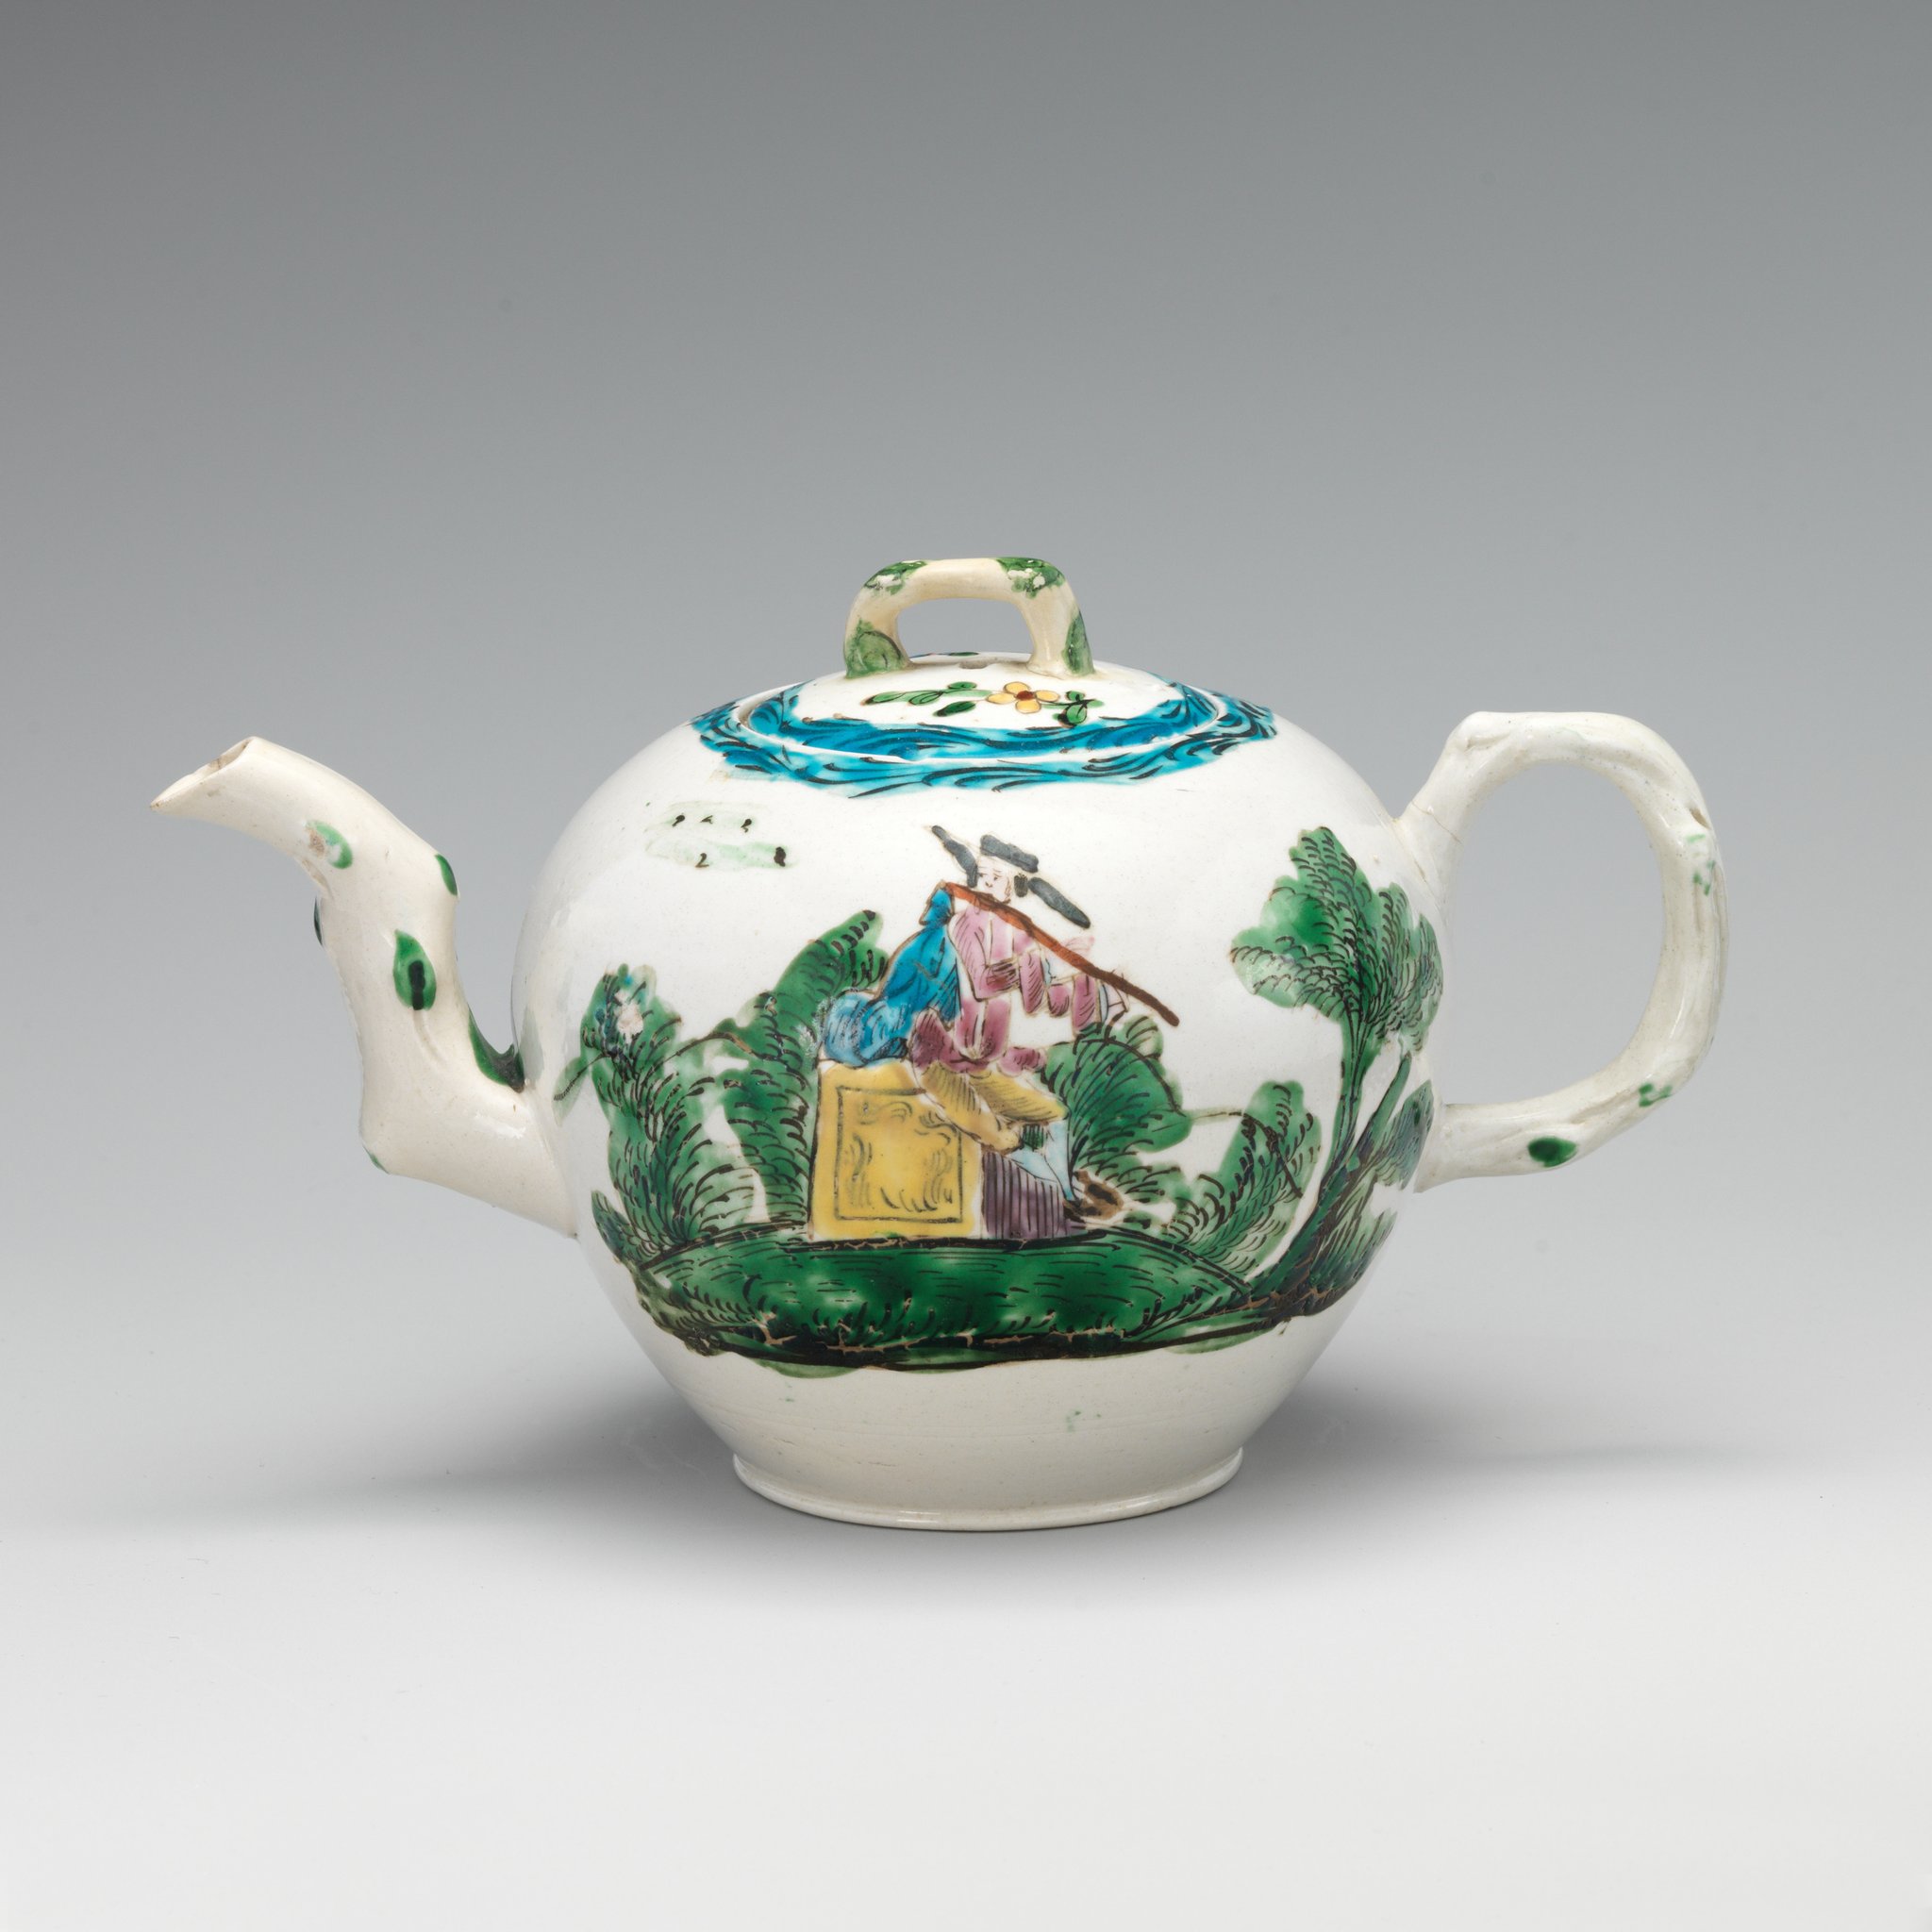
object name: teapot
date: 1765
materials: stoneware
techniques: salt glaze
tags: men,flutes